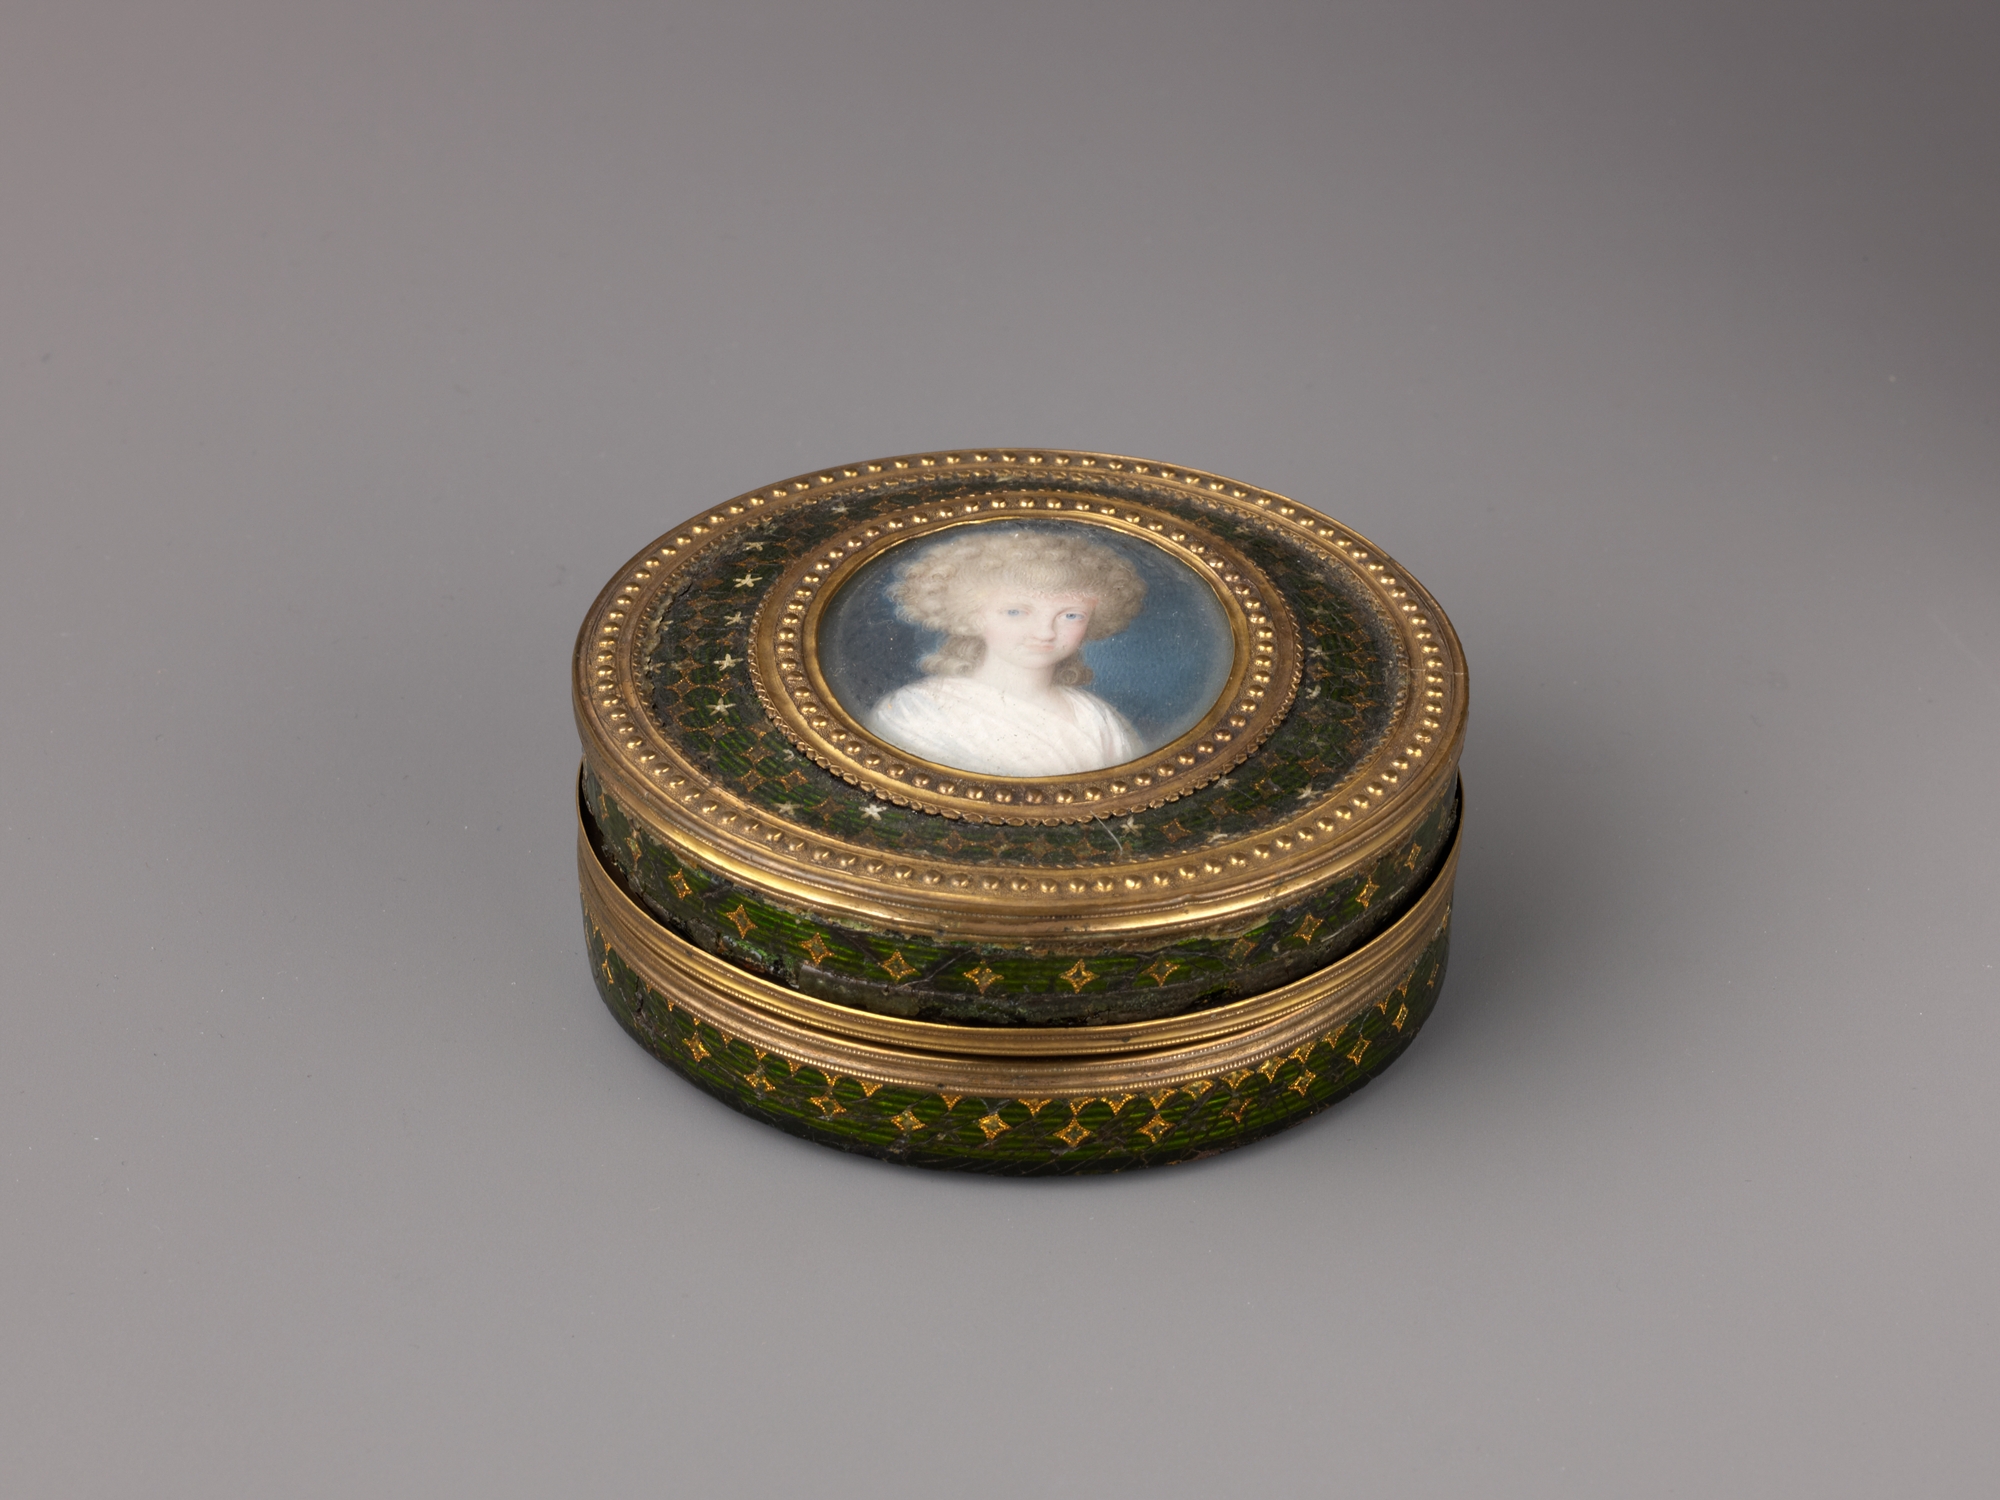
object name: snuffbox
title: Snuffbox with a Portrait of a Woman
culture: french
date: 1785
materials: copper alloy, gilt, horn, paper, shell, parchment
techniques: veneering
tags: portraits,women